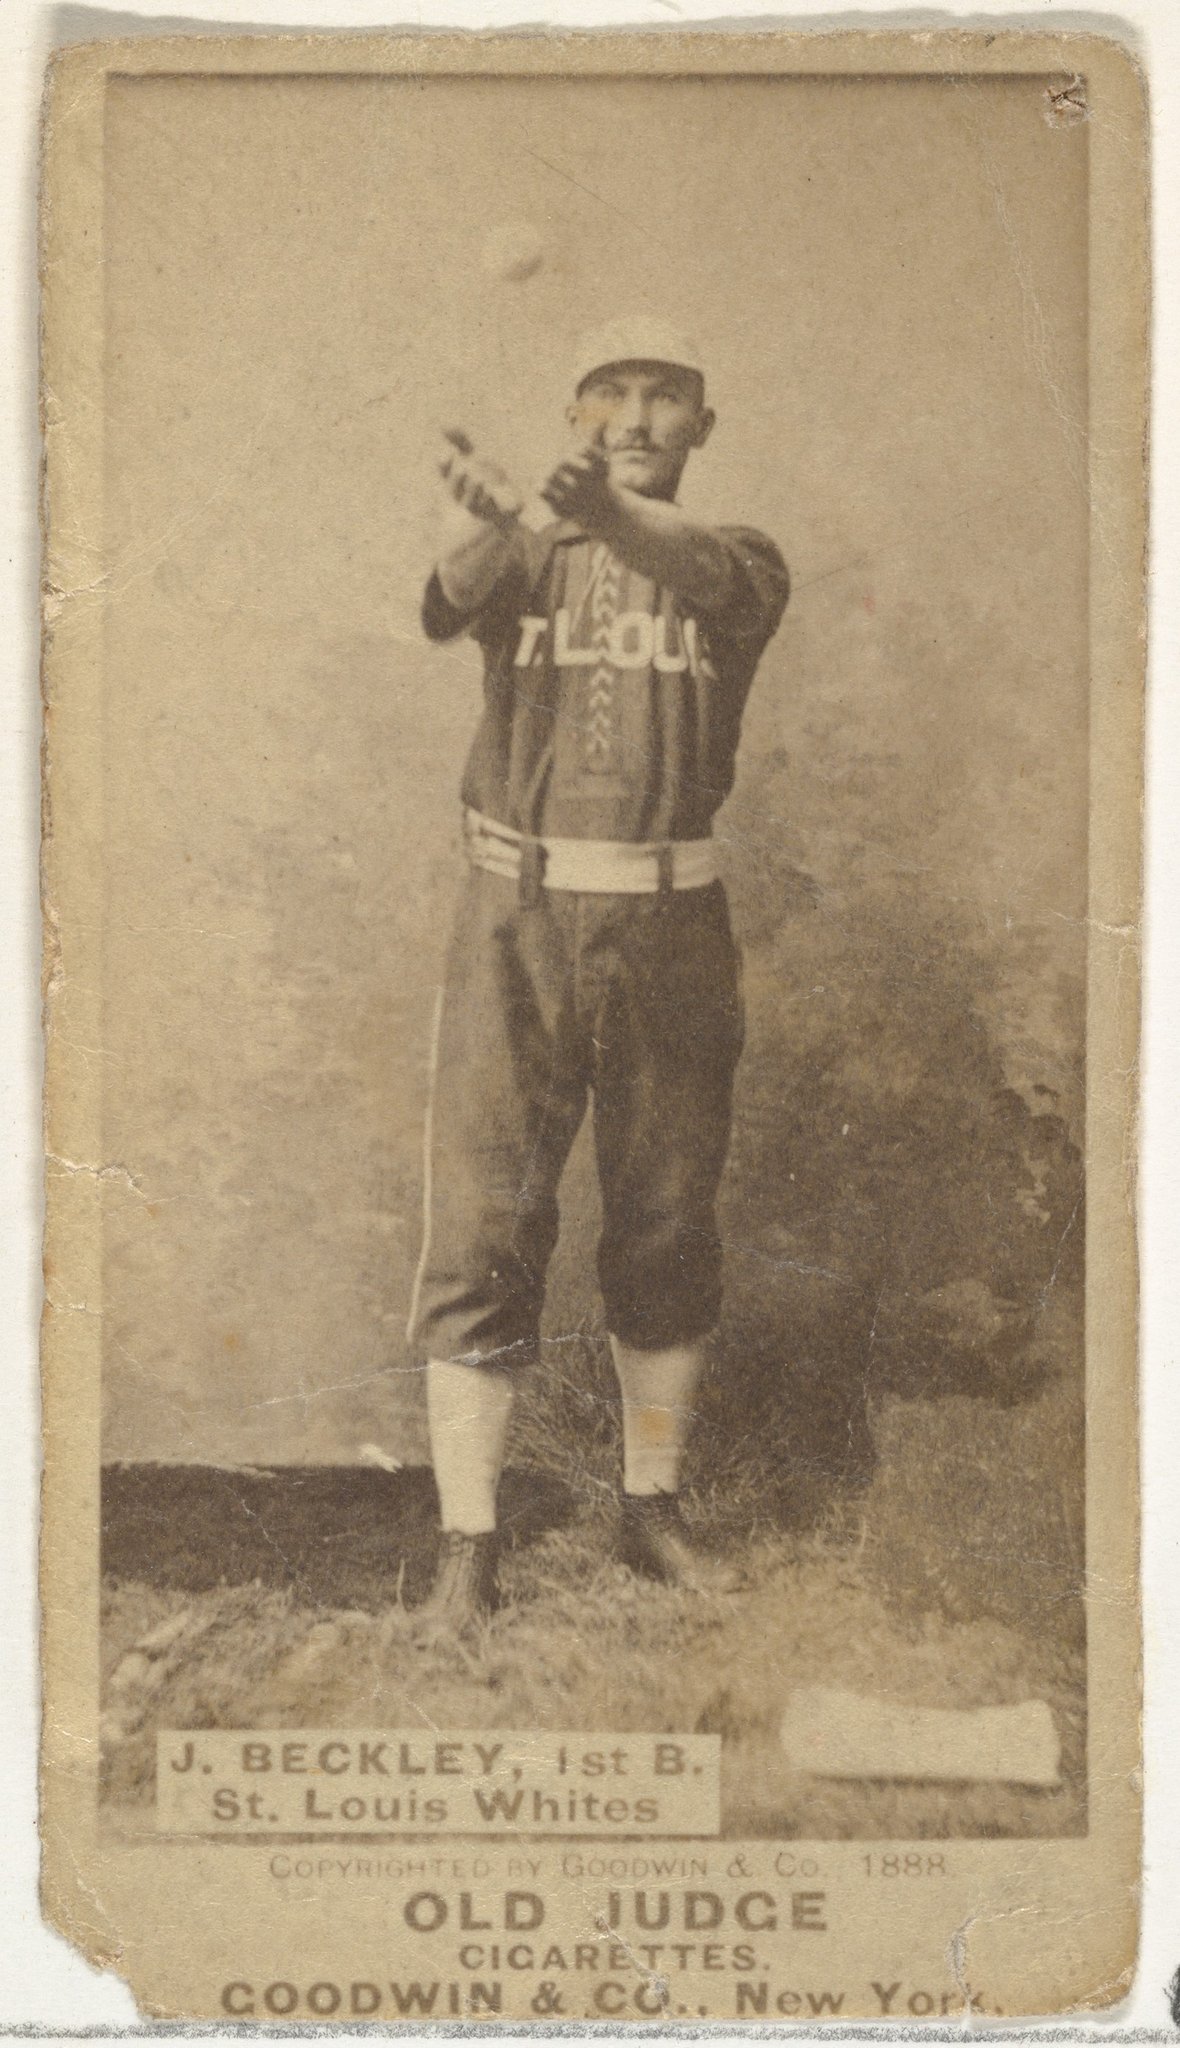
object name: baseball card, photograph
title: Beckley, 1st Base, St. Louis Whites, from the Old Judge series (N172) for Old Judge Cigarettes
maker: goodwin & company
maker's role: publisher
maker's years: 1850-1950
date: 1888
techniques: albumen silver print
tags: men,portraits,baseball,athletes